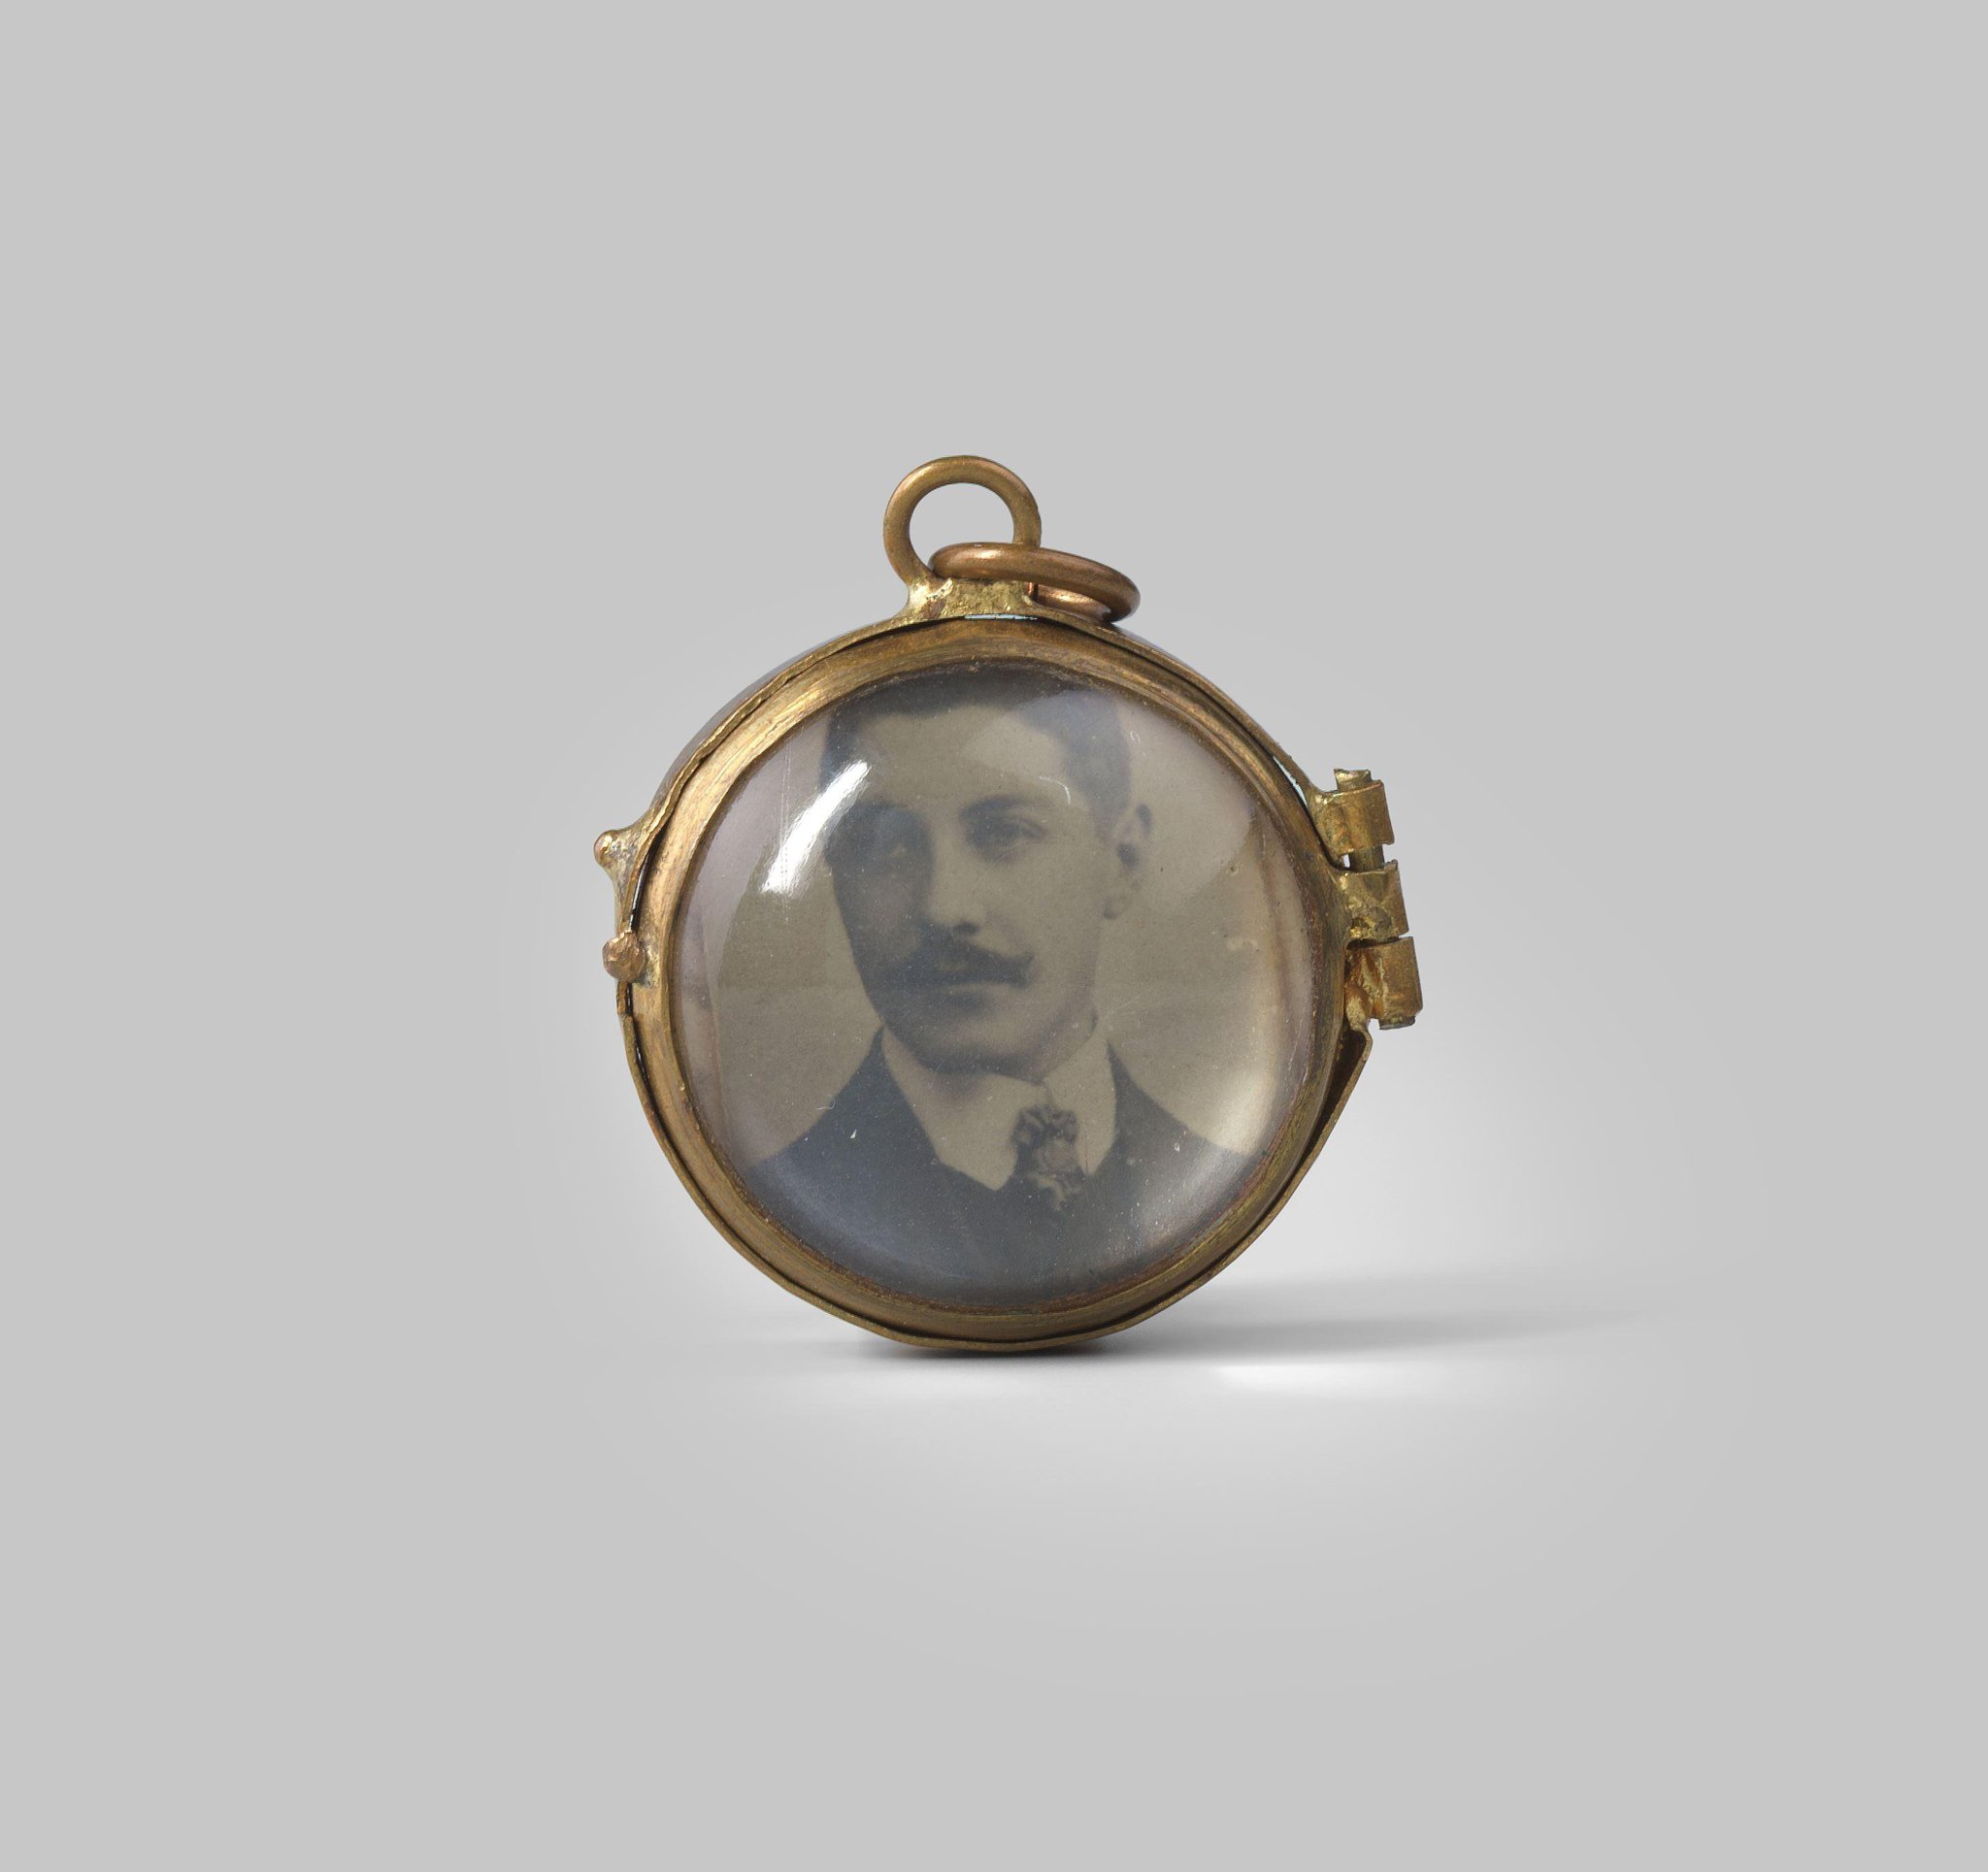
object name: locket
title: Portret van een onbekende jongeman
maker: Anonymous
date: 1880-1910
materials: paper, glass, metal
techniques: gelatin silver print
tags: historical persons